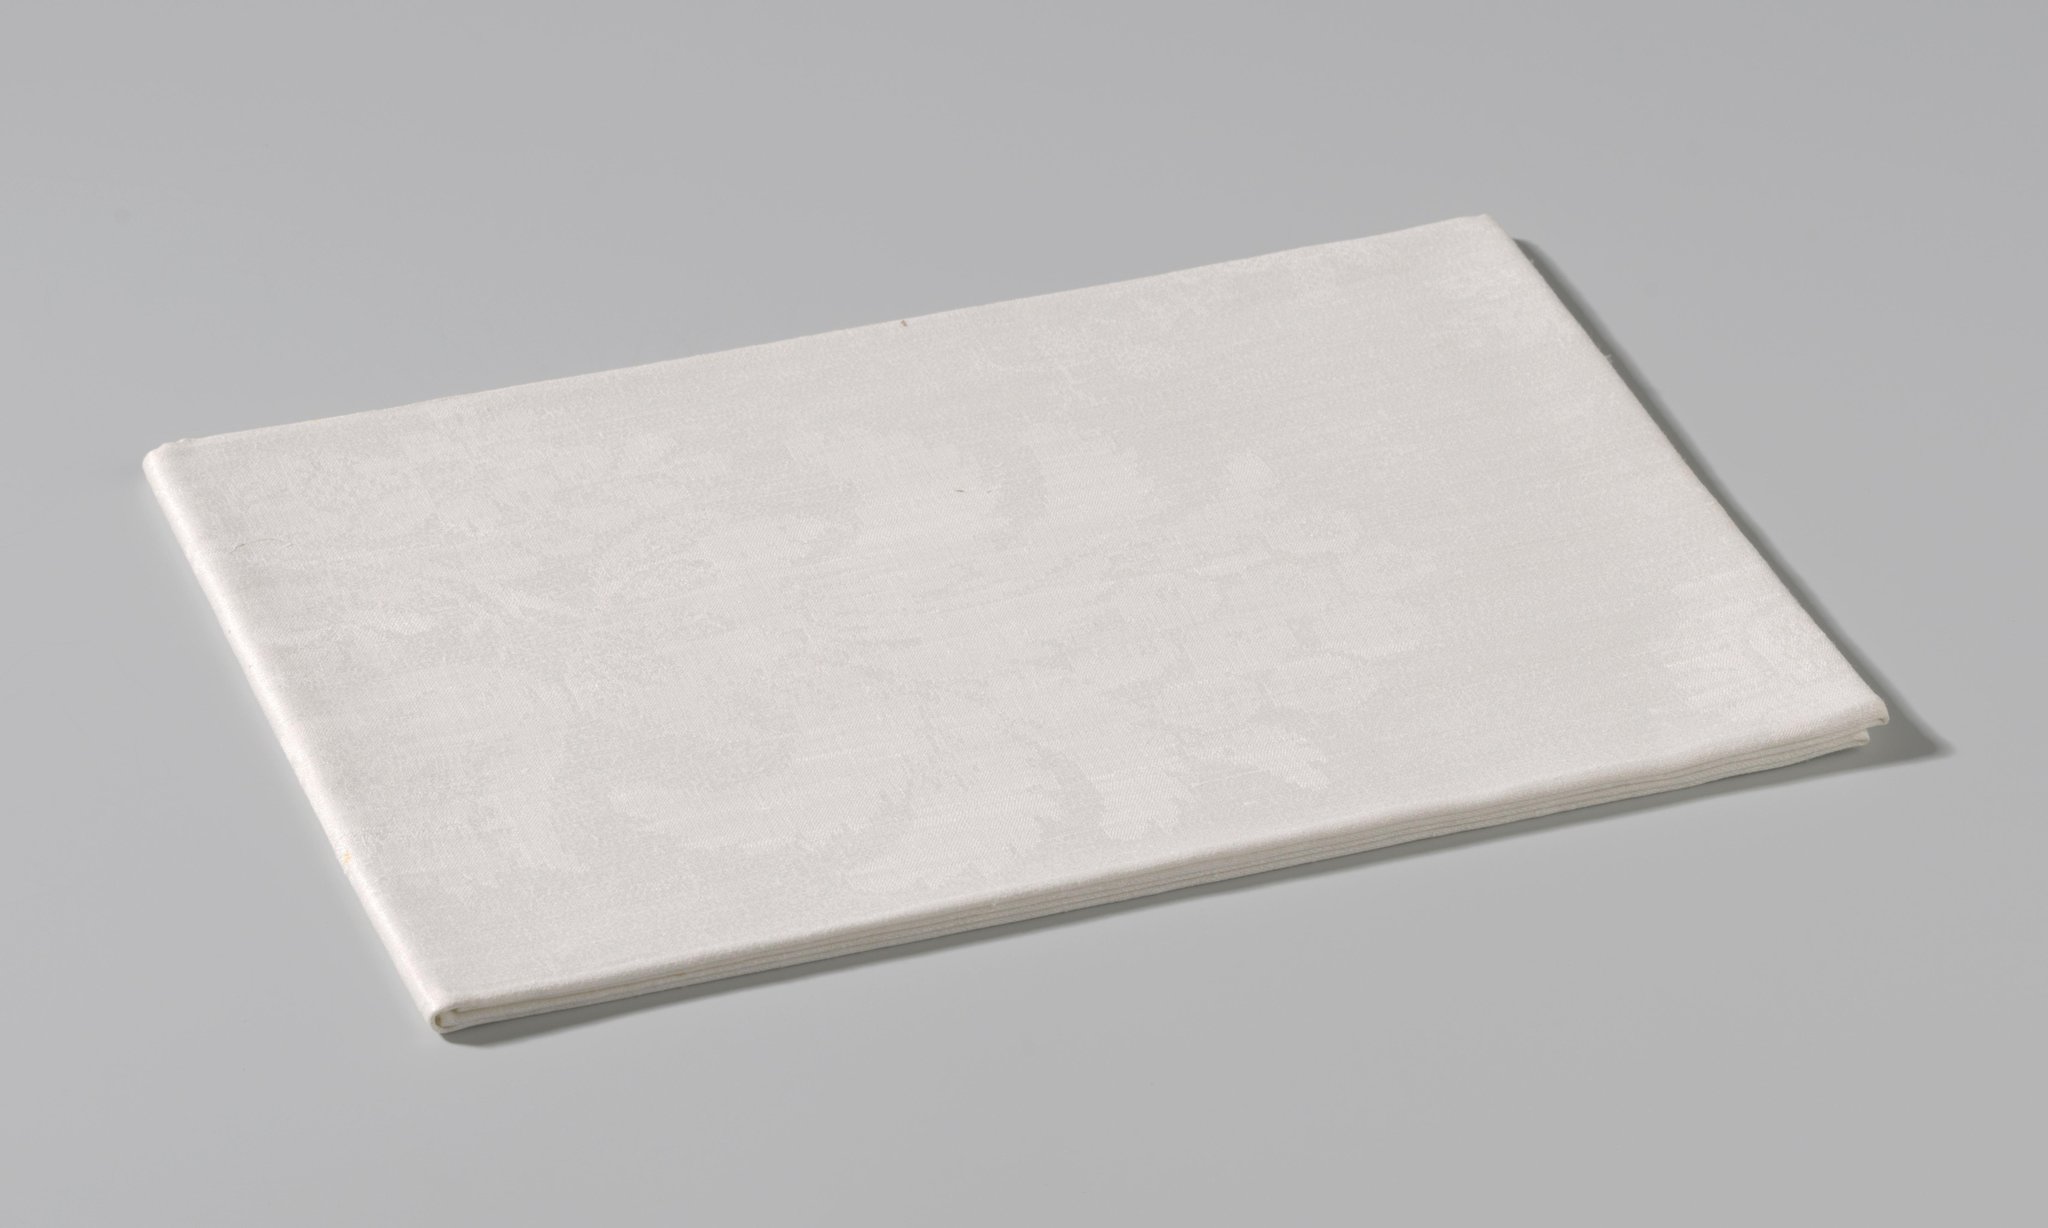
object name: napkin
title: Servet van linnendamast met een bloempatroon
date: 1740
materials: linen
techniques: damask, weave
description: Servet van linnendamast met een bloempatroon. Het servet hoort bij vijf servetten (BK-1973-177-A t/m BK-1973-177-F) en een tafellaken (BK-1973-176).